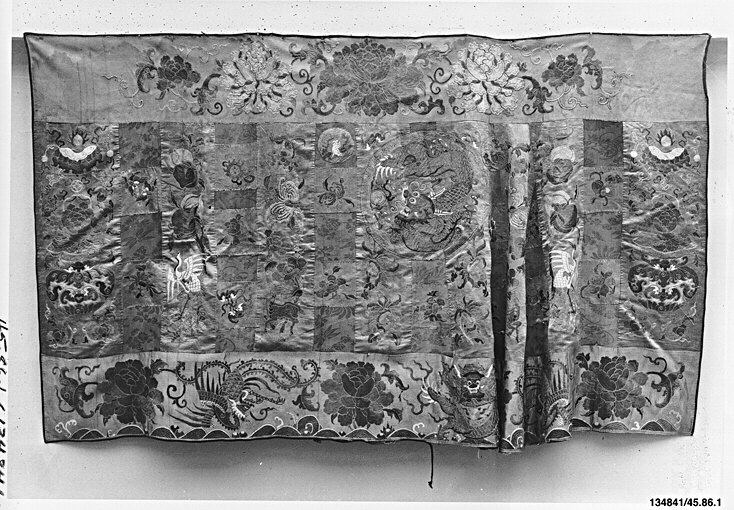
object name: robe, buddhist priest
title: Robe for Buddhist Priest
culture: chinese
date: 1801-1900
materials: metal thread, silk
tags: dragons